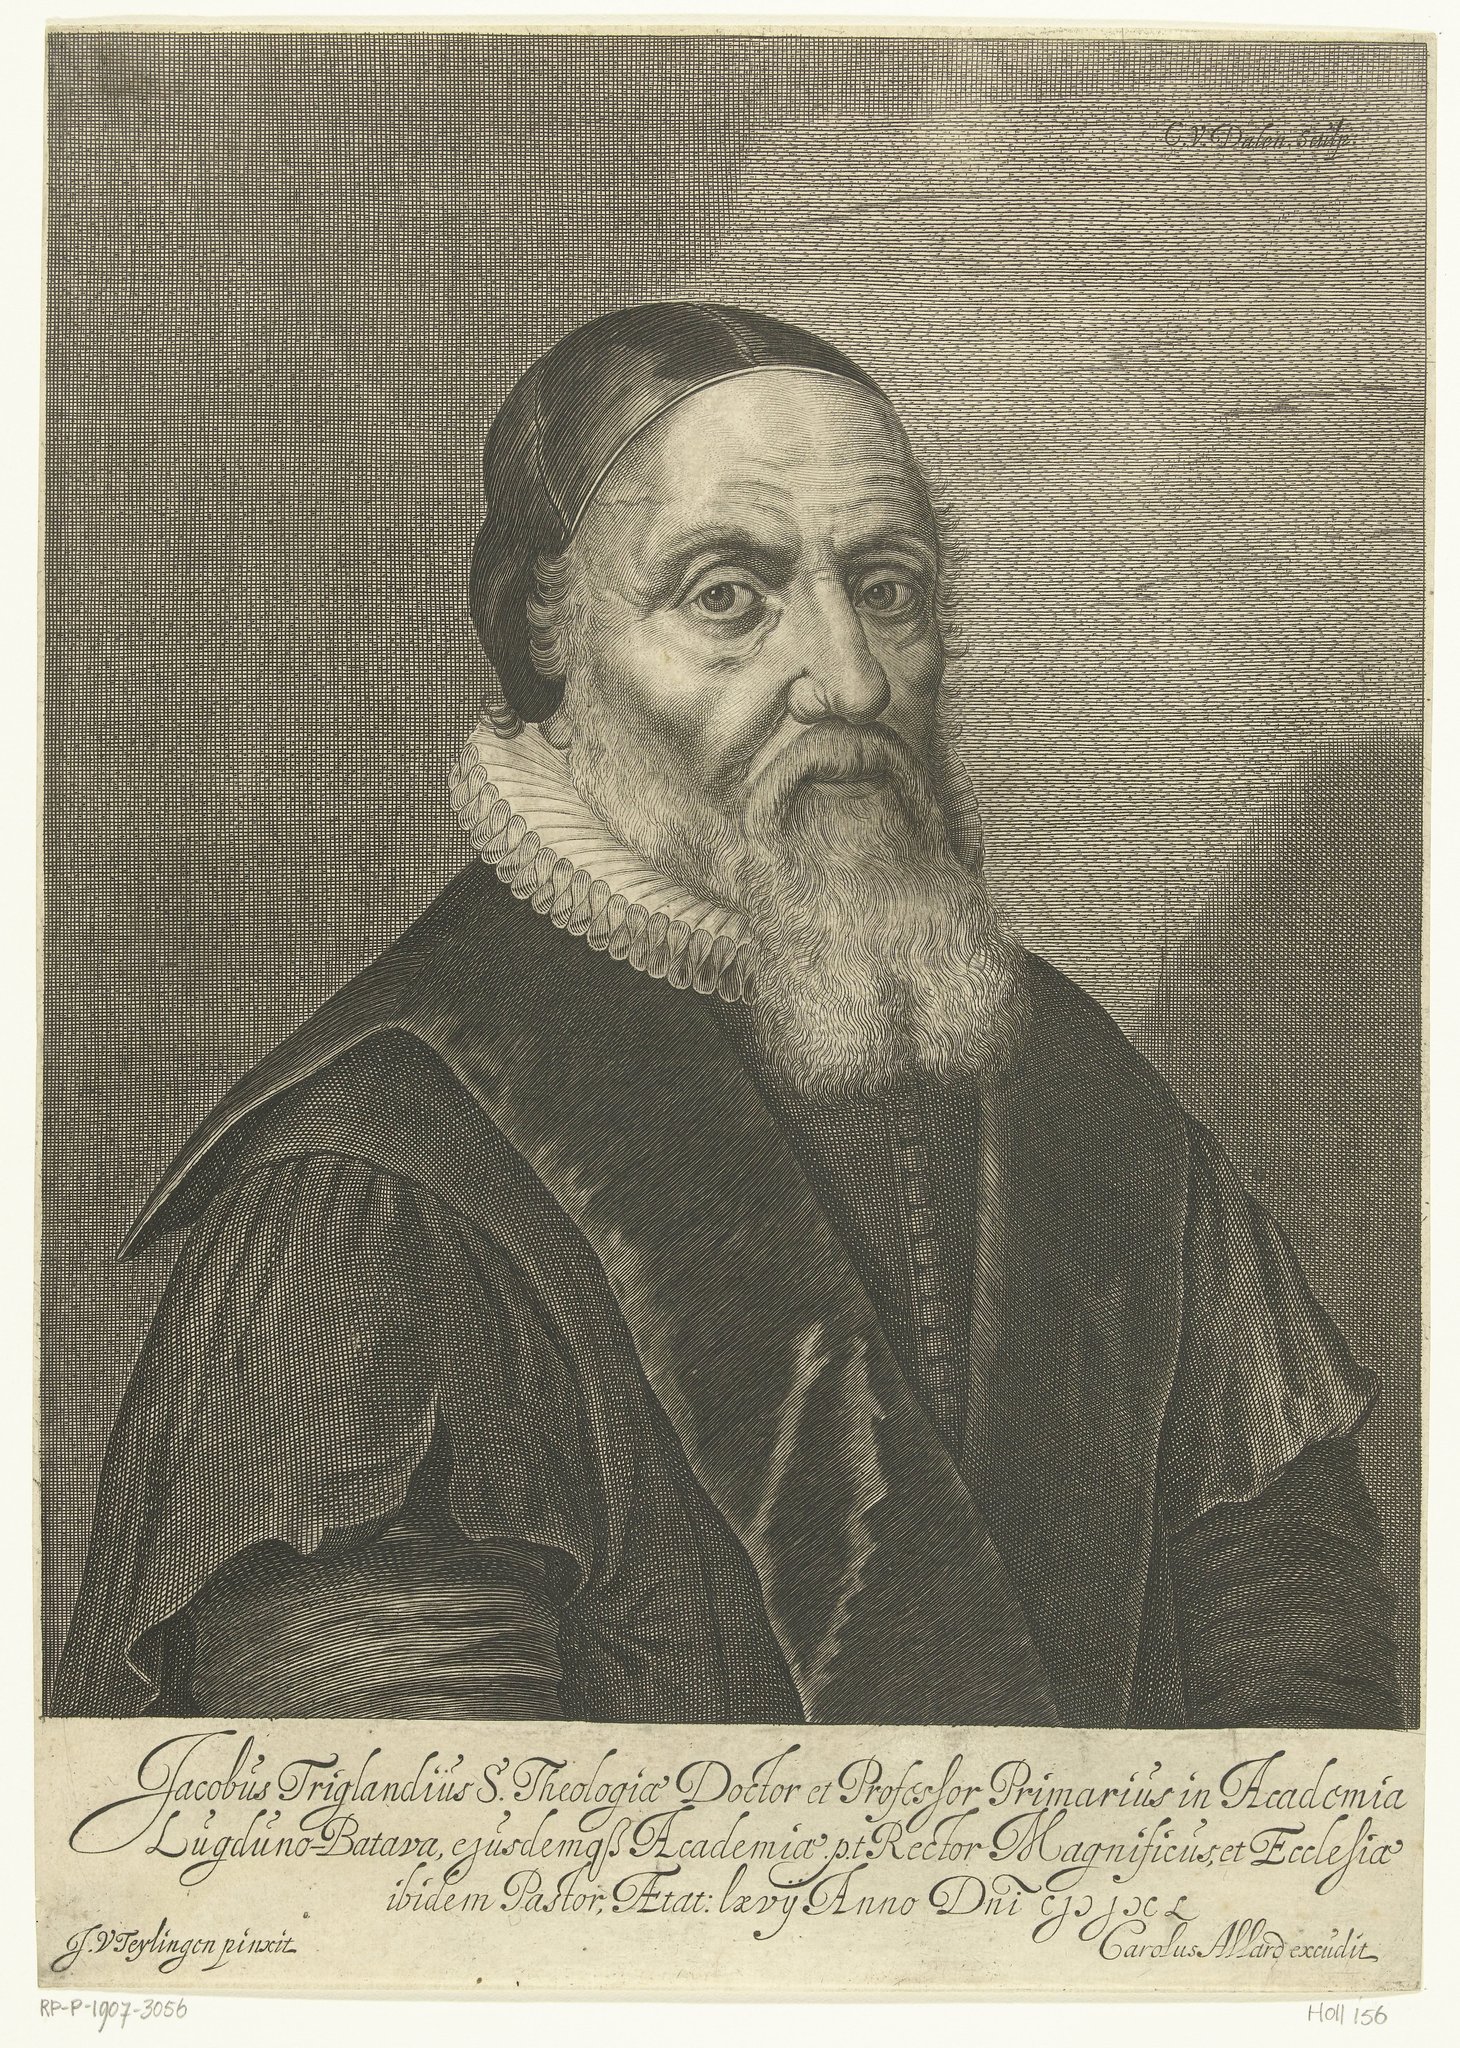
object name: print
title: Portret van Jacobus Trigland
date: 1612-1665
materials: paper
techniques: engraving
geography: amsterdam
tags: jacobus trigland (i)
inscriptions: collector's mark: Lugt 2228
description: Portret van Jacobus Trigland. Borststuk van de theoloog gekleed in toga.